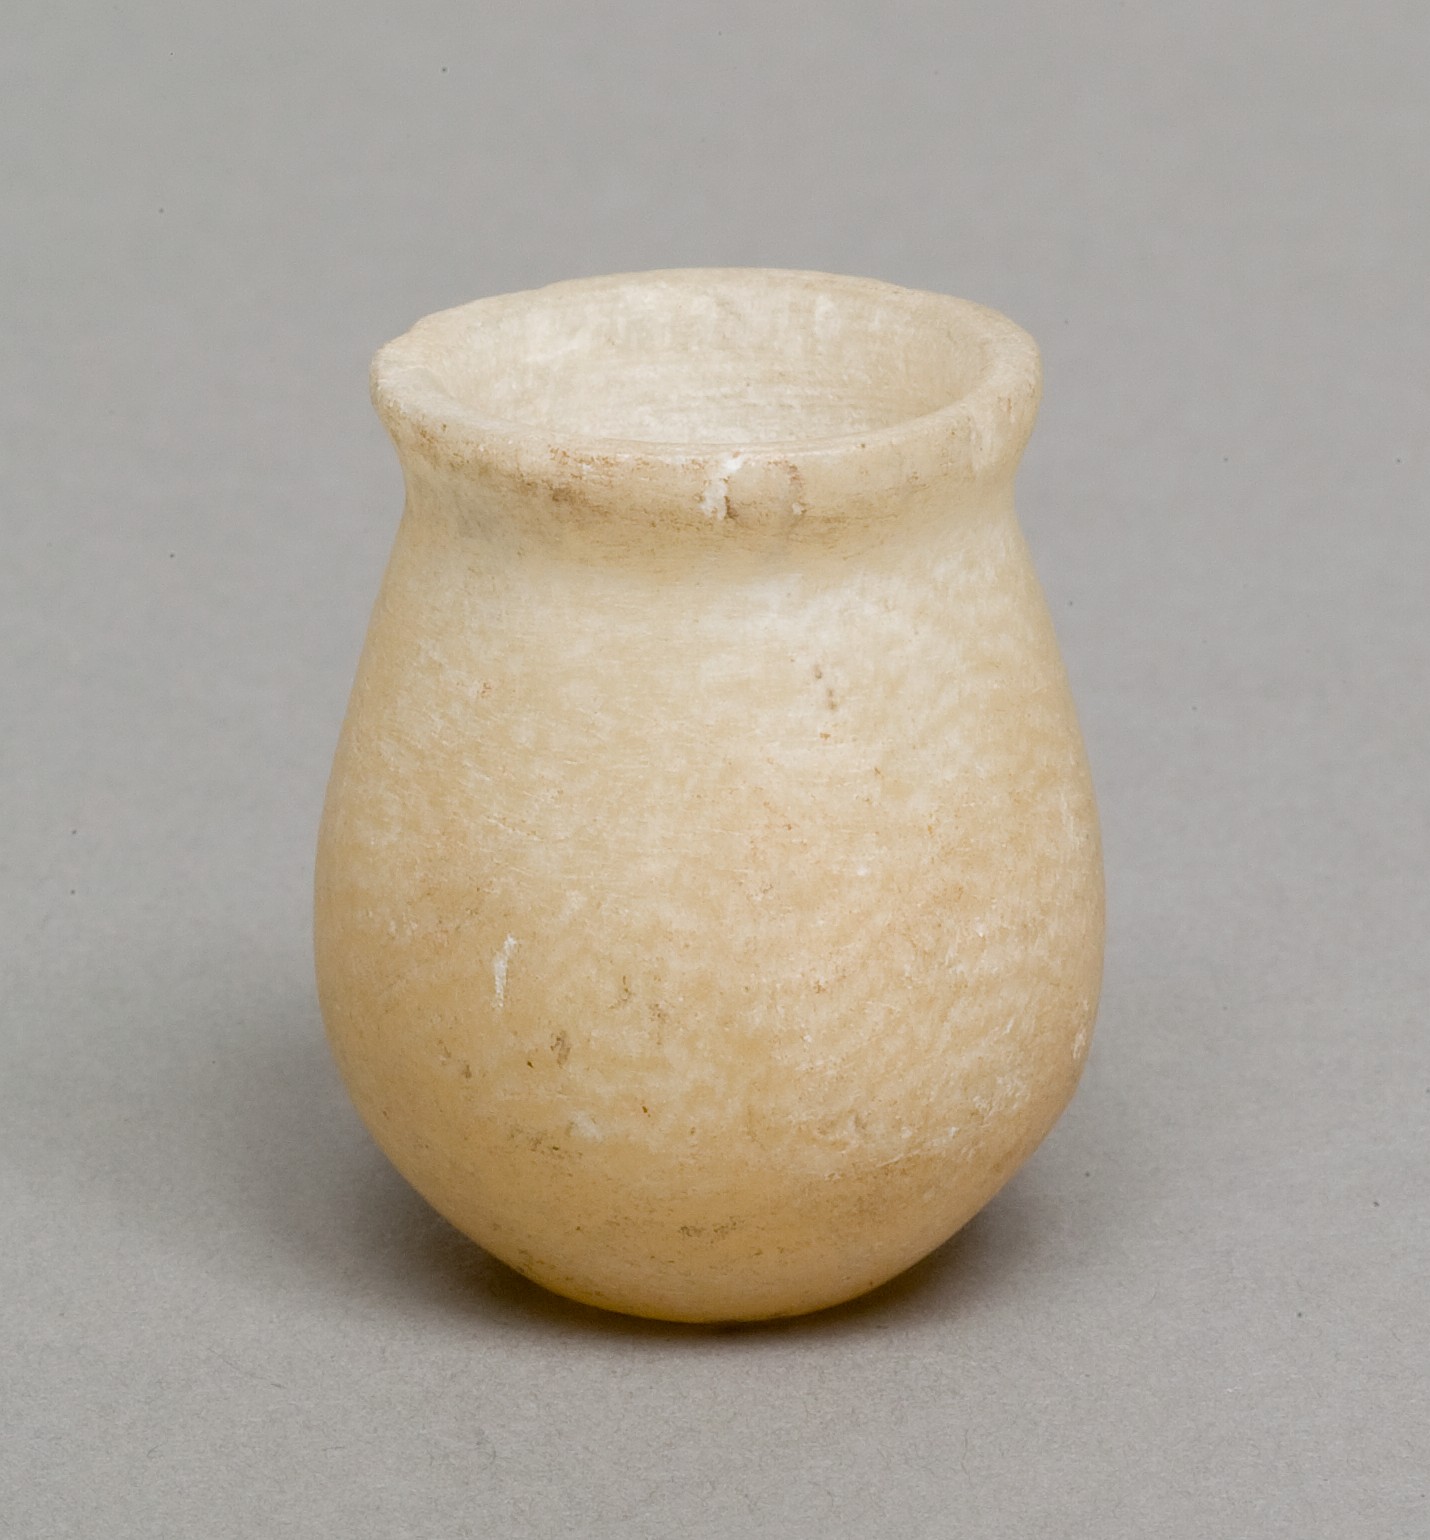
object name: cosmetic jar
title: Toilet vase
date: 1750 BCE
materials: stone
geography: egypt